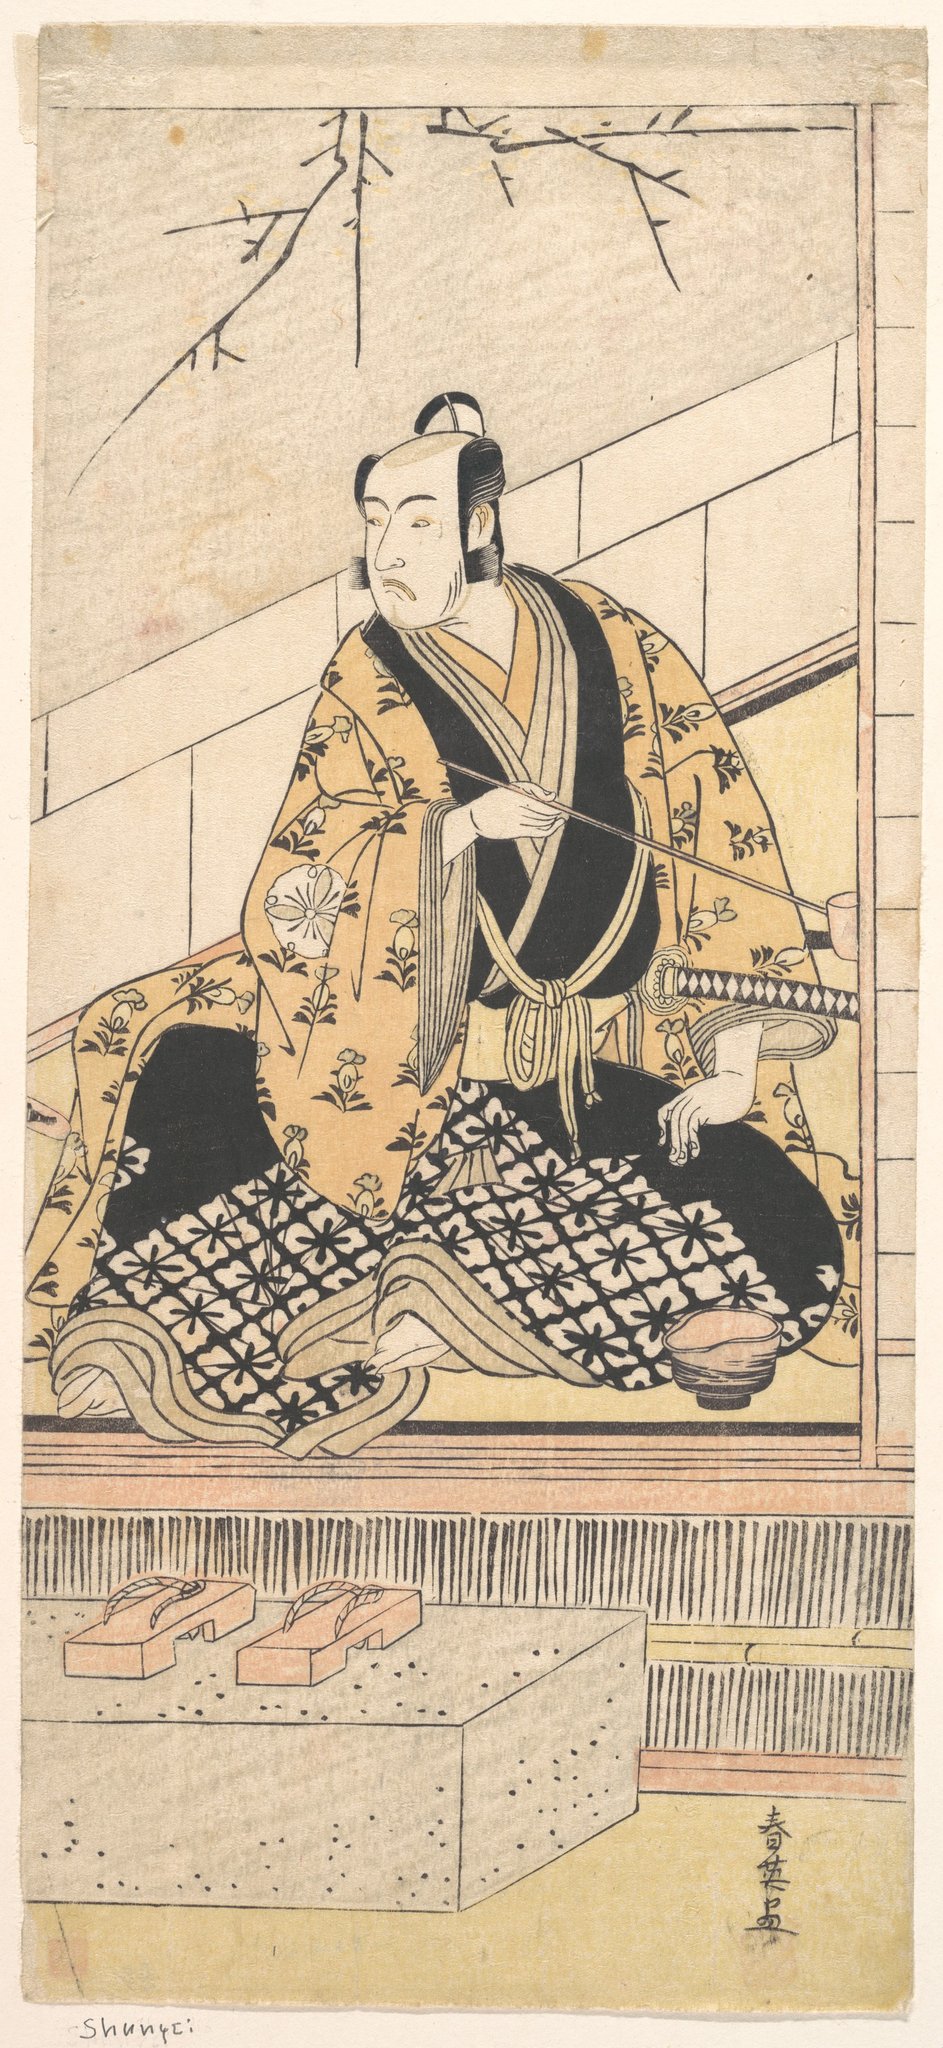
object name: print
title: The Actor Matsumoto Koshiro IV Seated in an Outer Room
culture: japanese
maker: katsukawa shun'ei 勝川春英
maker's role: artist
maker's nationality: japanese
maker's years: 1762-1819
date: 1789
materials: ink, paper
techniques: woodblock print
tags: men,actors